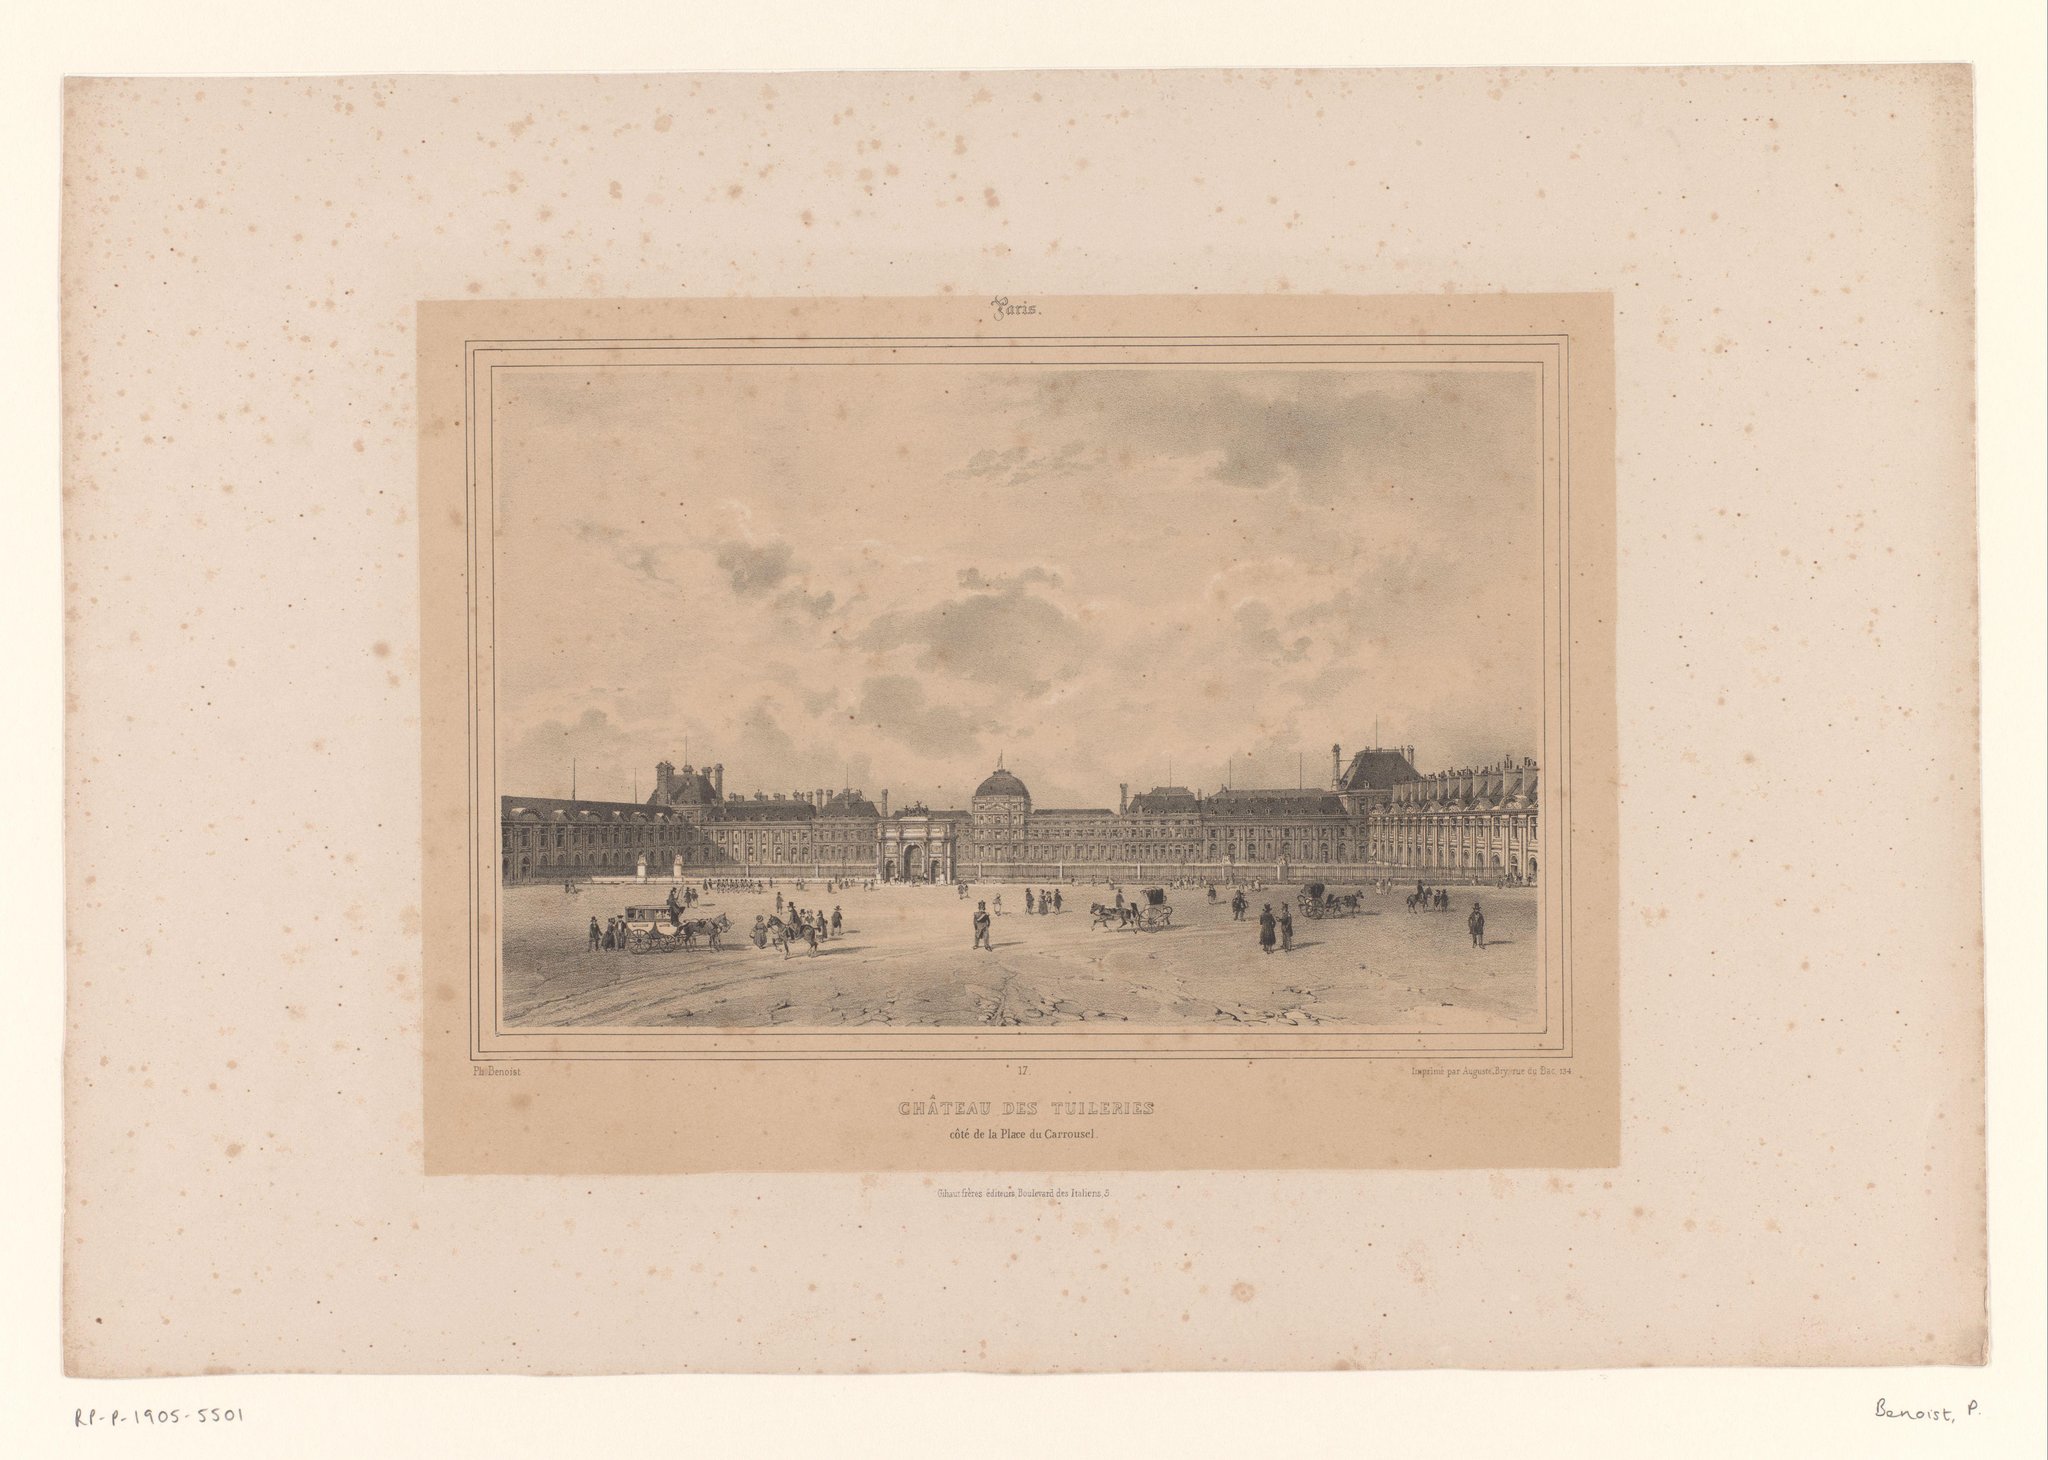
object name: print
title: Château des Tuileries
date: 1843-1844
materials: paper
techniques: tone lithography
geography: paris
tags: palace, tuileries palace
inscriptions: collector's mark: Lugt 2228a